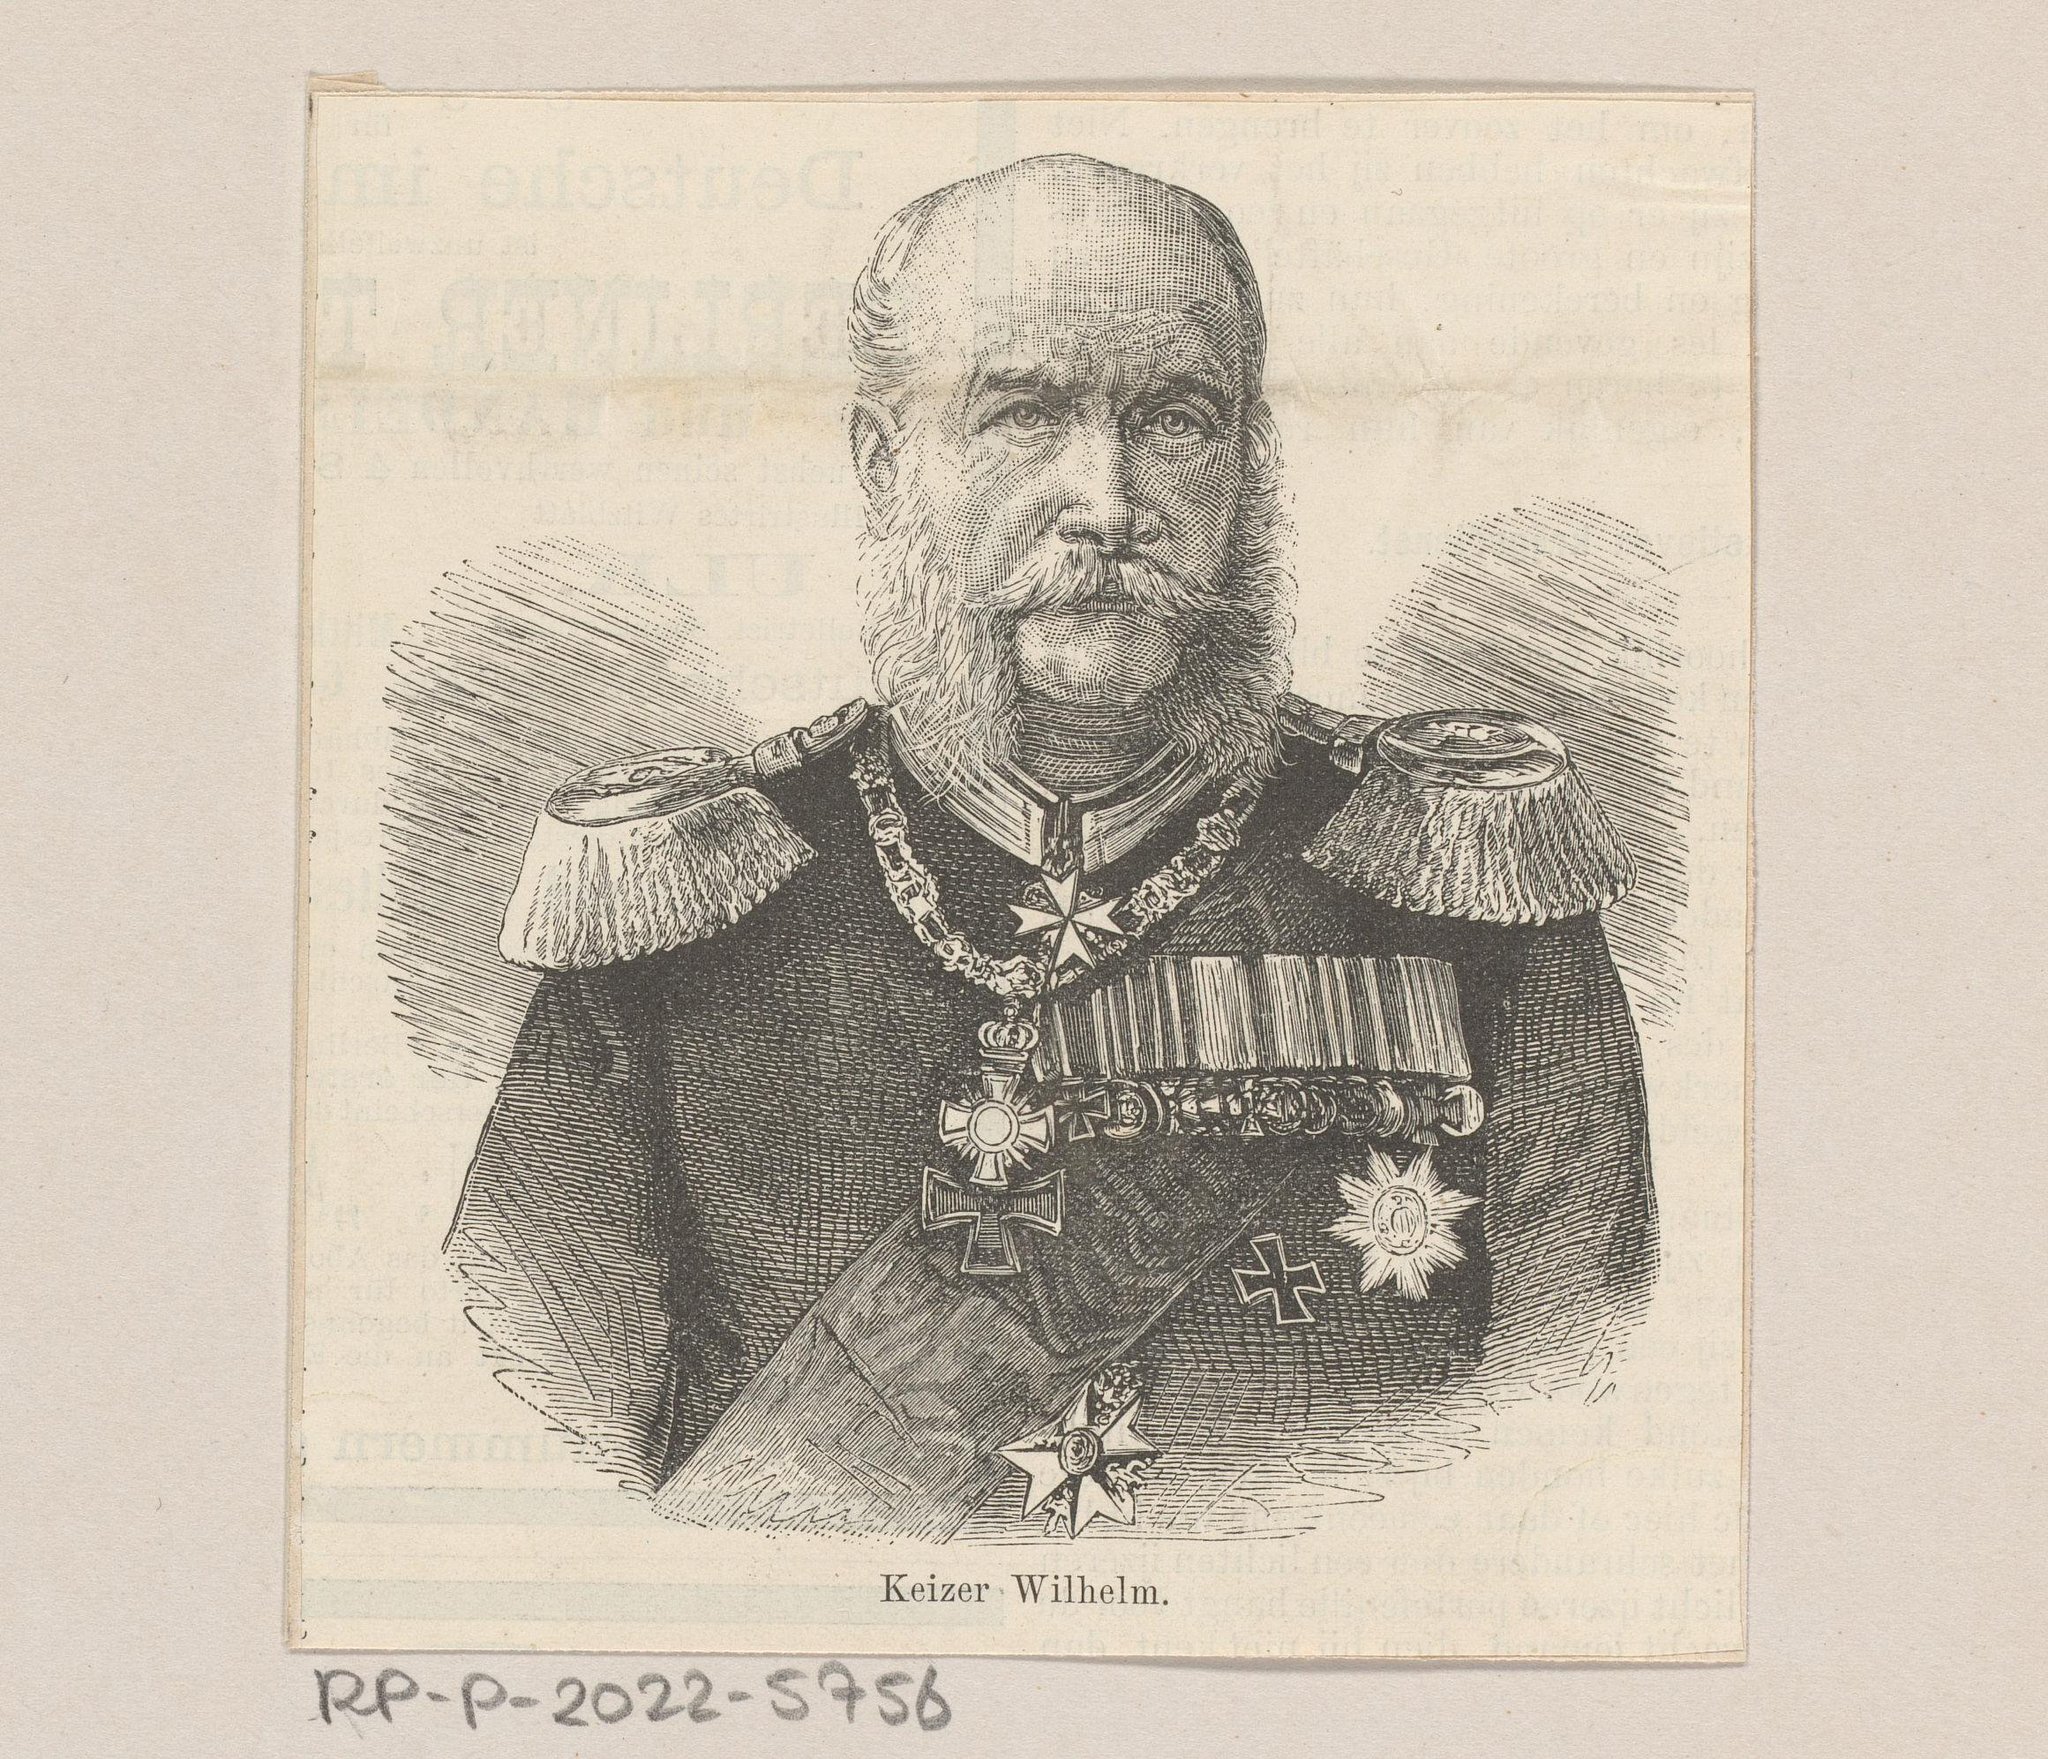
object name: print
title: Portret van Wilhelm I van Duitsland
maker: Anonymous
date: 1871-1888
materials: paper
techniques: letterpress printing, engraving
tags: berlin, wilhelm i (keizer van duitsland), historical persons, ranks ~ rulers, sovereigns